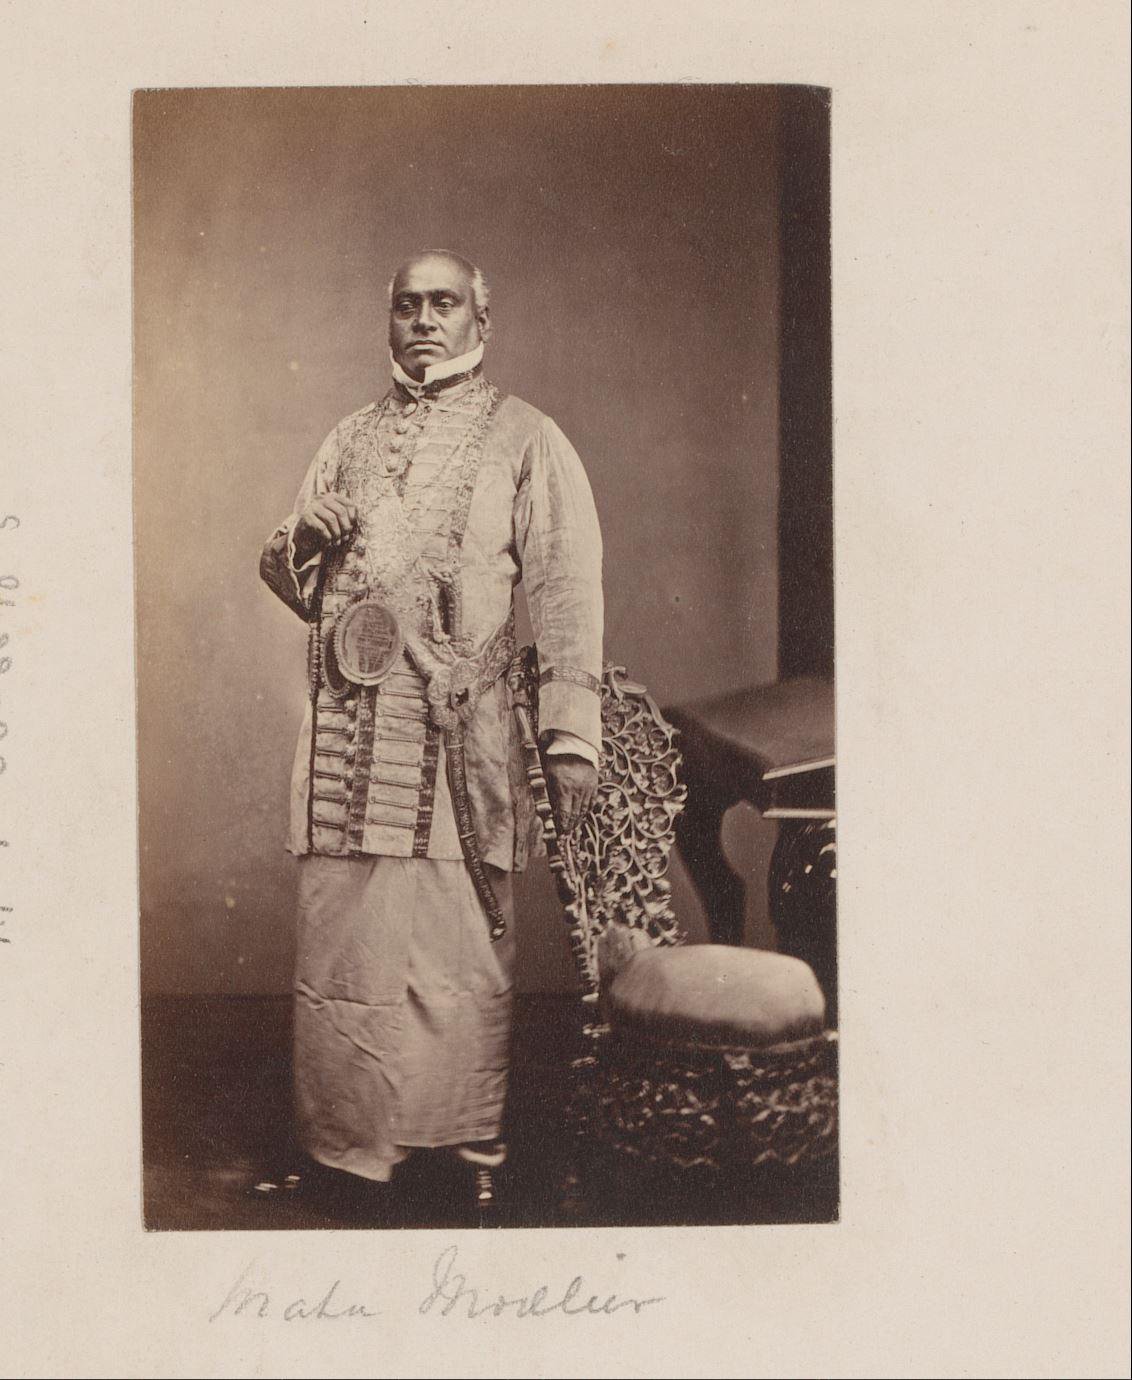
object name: photograph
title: Portrait of a man with a sword and a chair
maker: Anonymous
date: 1880-1900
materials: cardboard, paper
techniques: albumen print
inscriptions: caption: ‘Mata Modlien [?]’, number: ‘1596’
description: Portret van een man ten voeten uit, in een studio gemaakt. Object zit samen met de andere foto's met nummer RP-F-00-6678 op één blad geplakt.